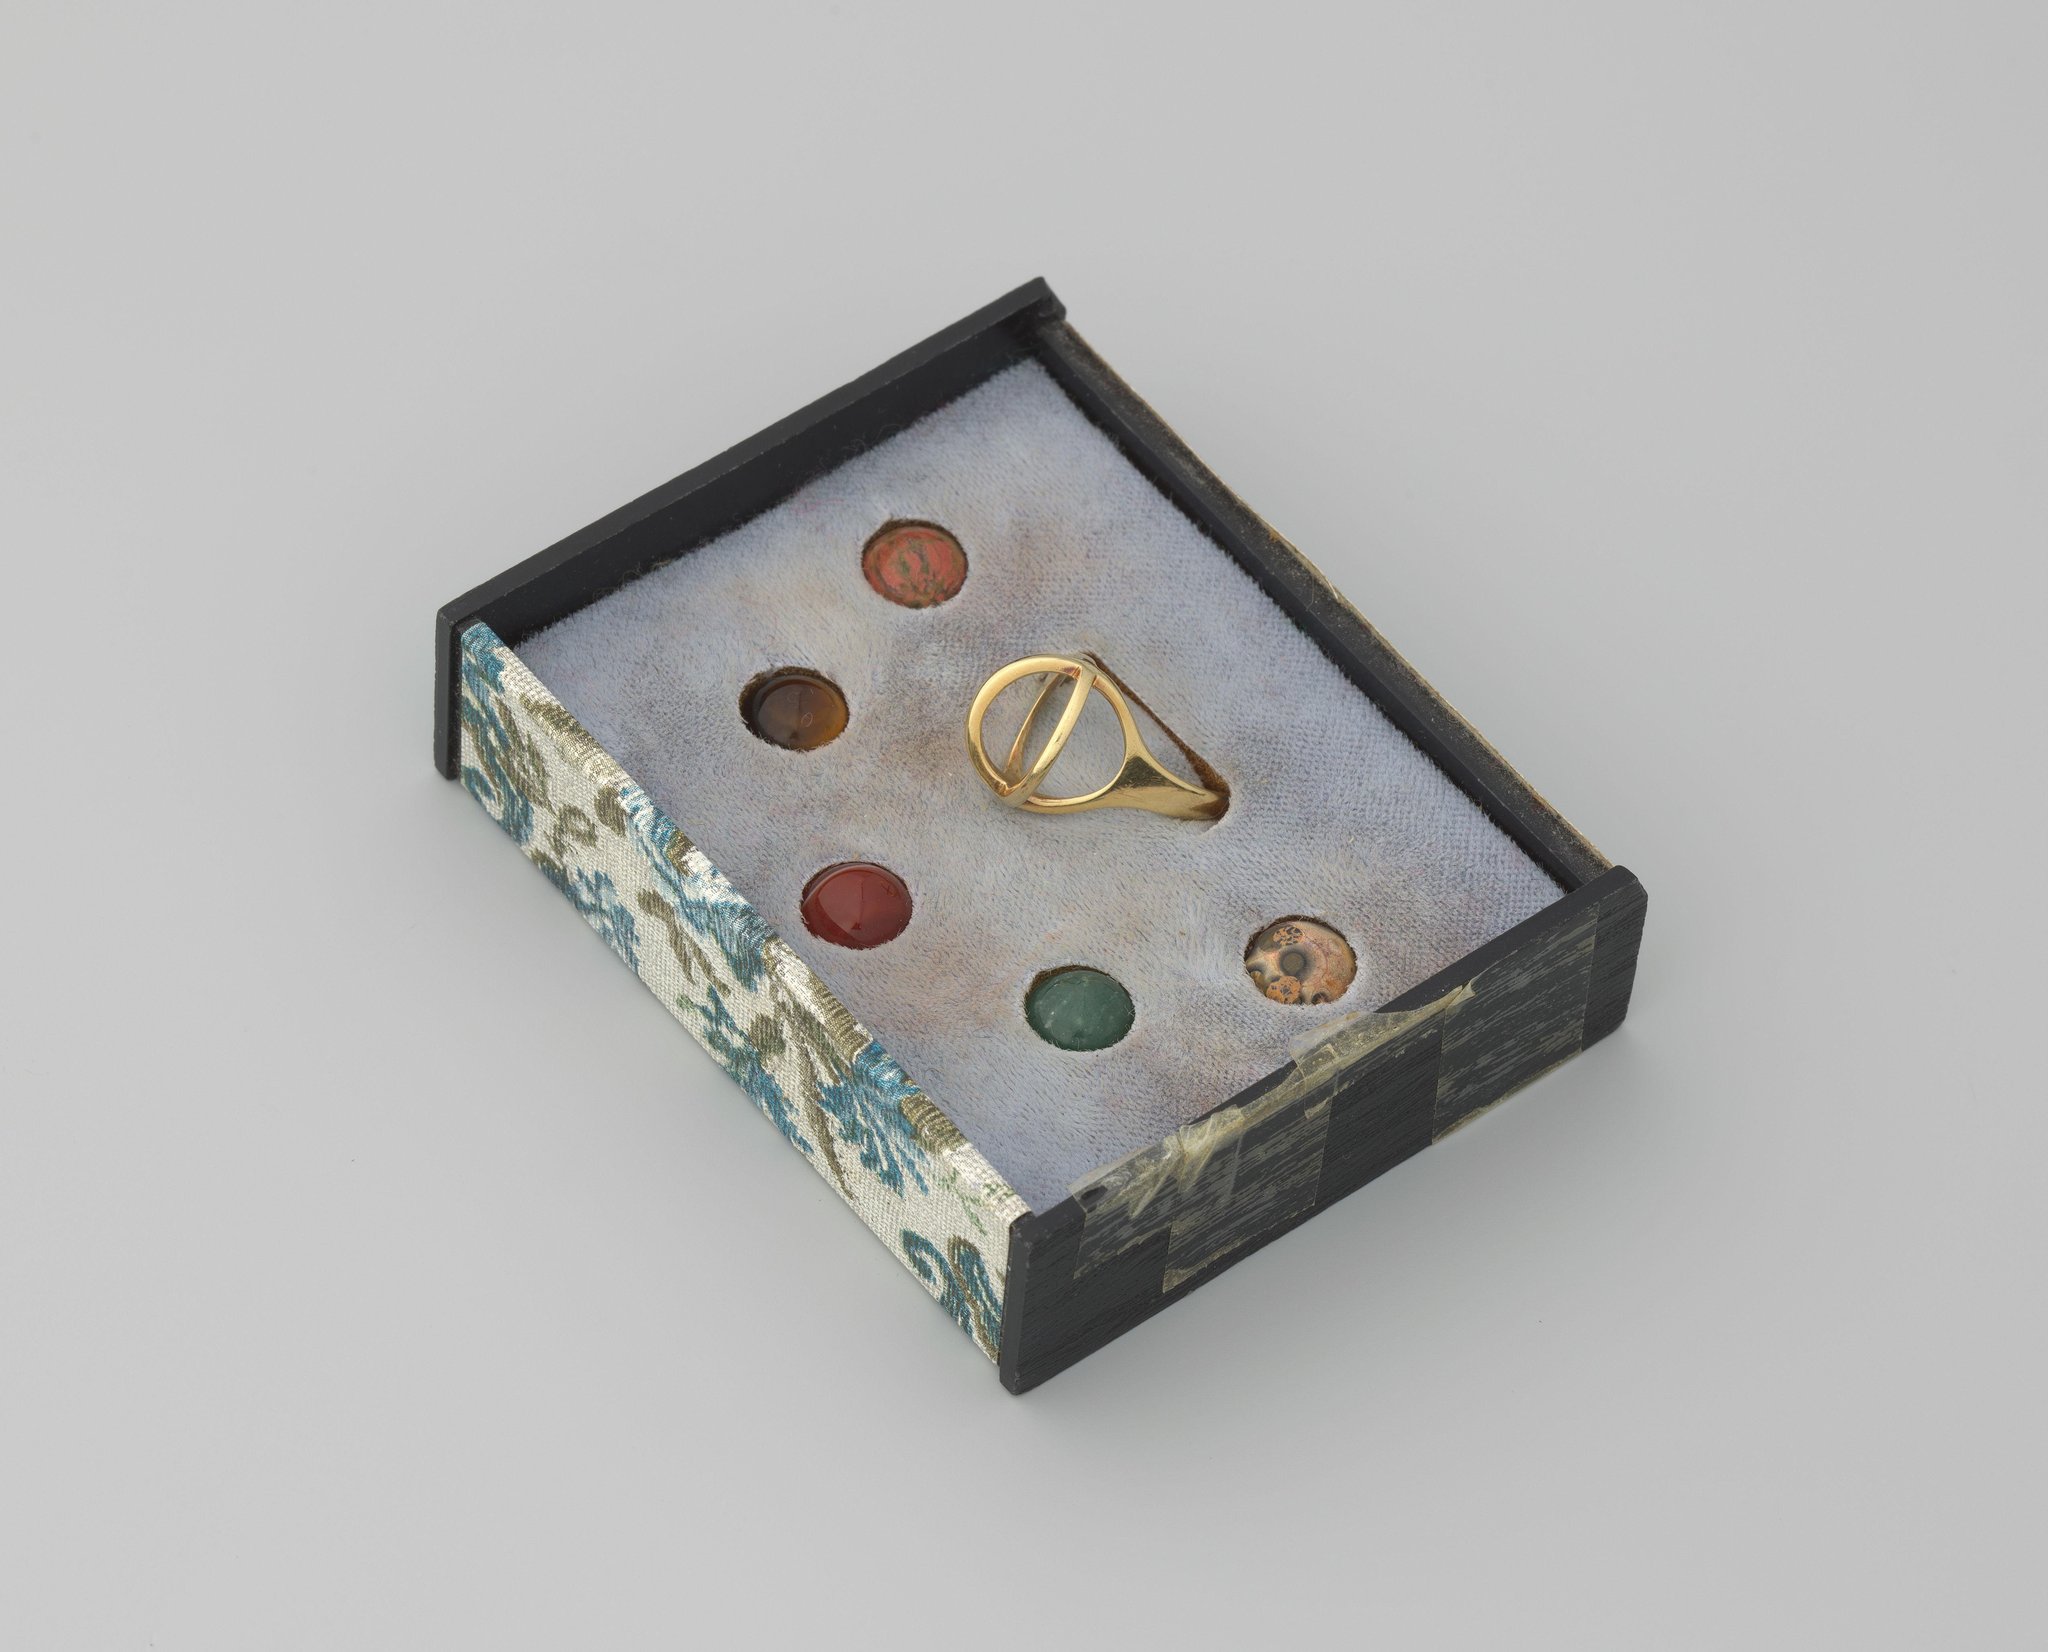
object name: ring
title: Wisselring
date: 1968-1970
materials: stone, cardboard, gemstone, gold, jasper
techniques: grinding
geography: voorschoten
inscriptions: maker's mark: ‘DCW’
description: Ring met vijf verschillende edelstenen (kwartsen) in kogelvorm die kunnen worden gewisseld in verpakking van karton waarvan het deksel ontbreekt.